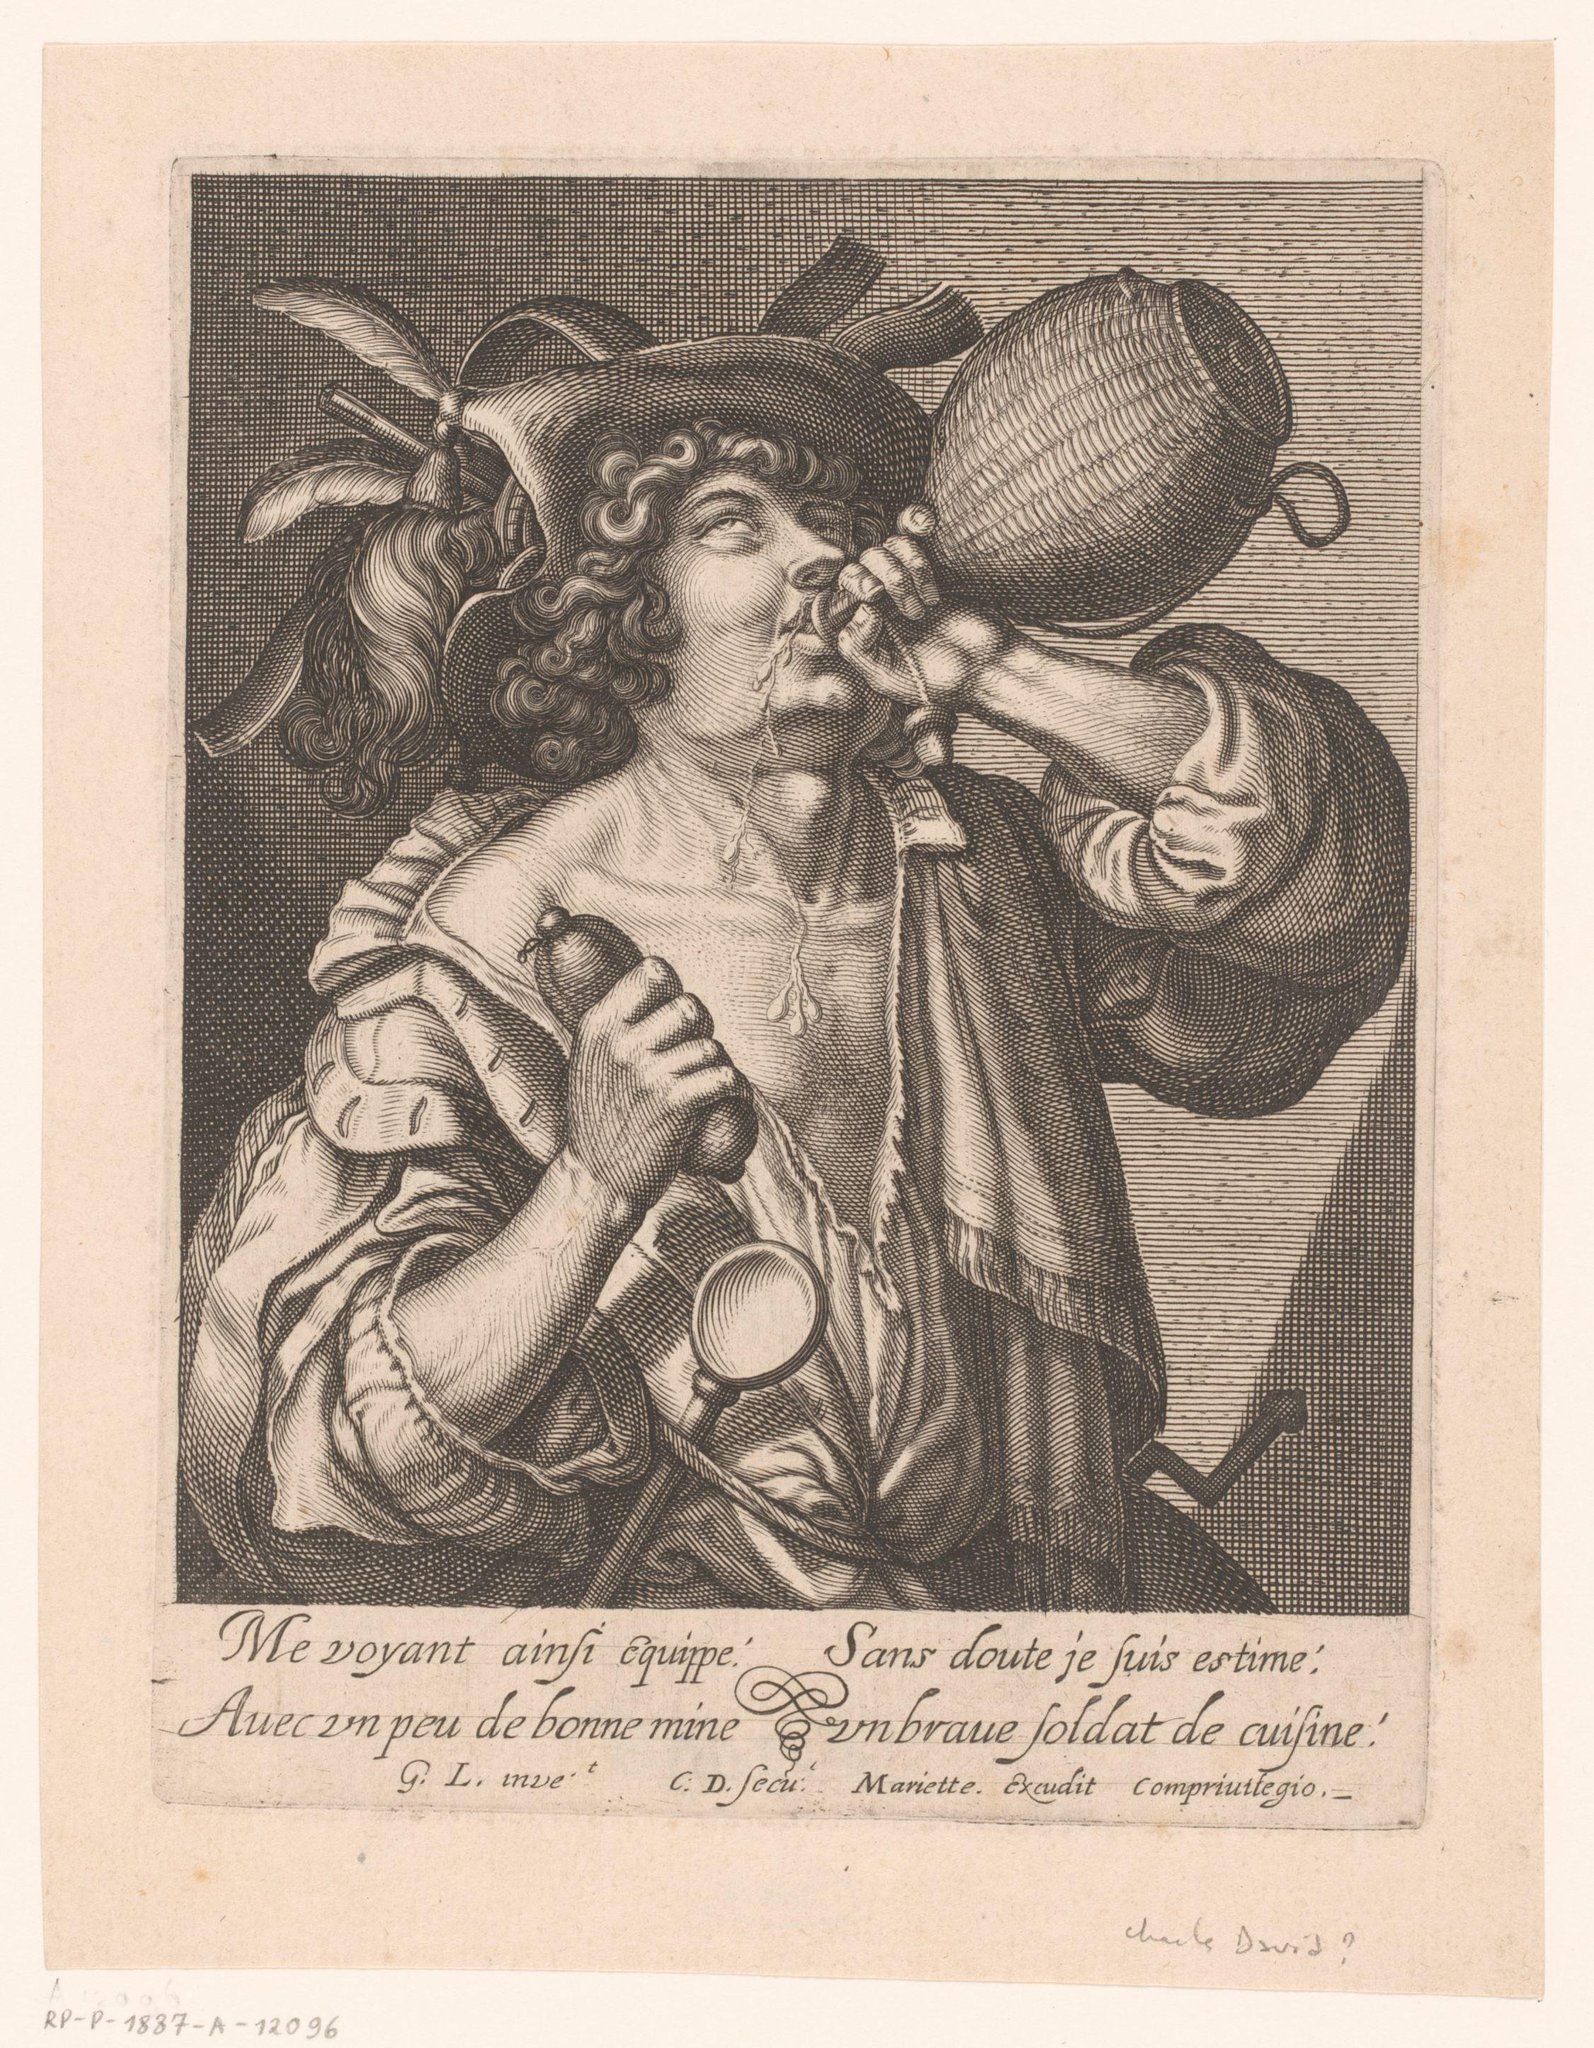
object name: print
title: Drinkende man met grote hoed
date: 1613-1638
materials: paper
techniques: engraving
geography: paris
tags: adult man, head-gear: hat, drinking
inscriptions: collector's mark: Lugt 2228